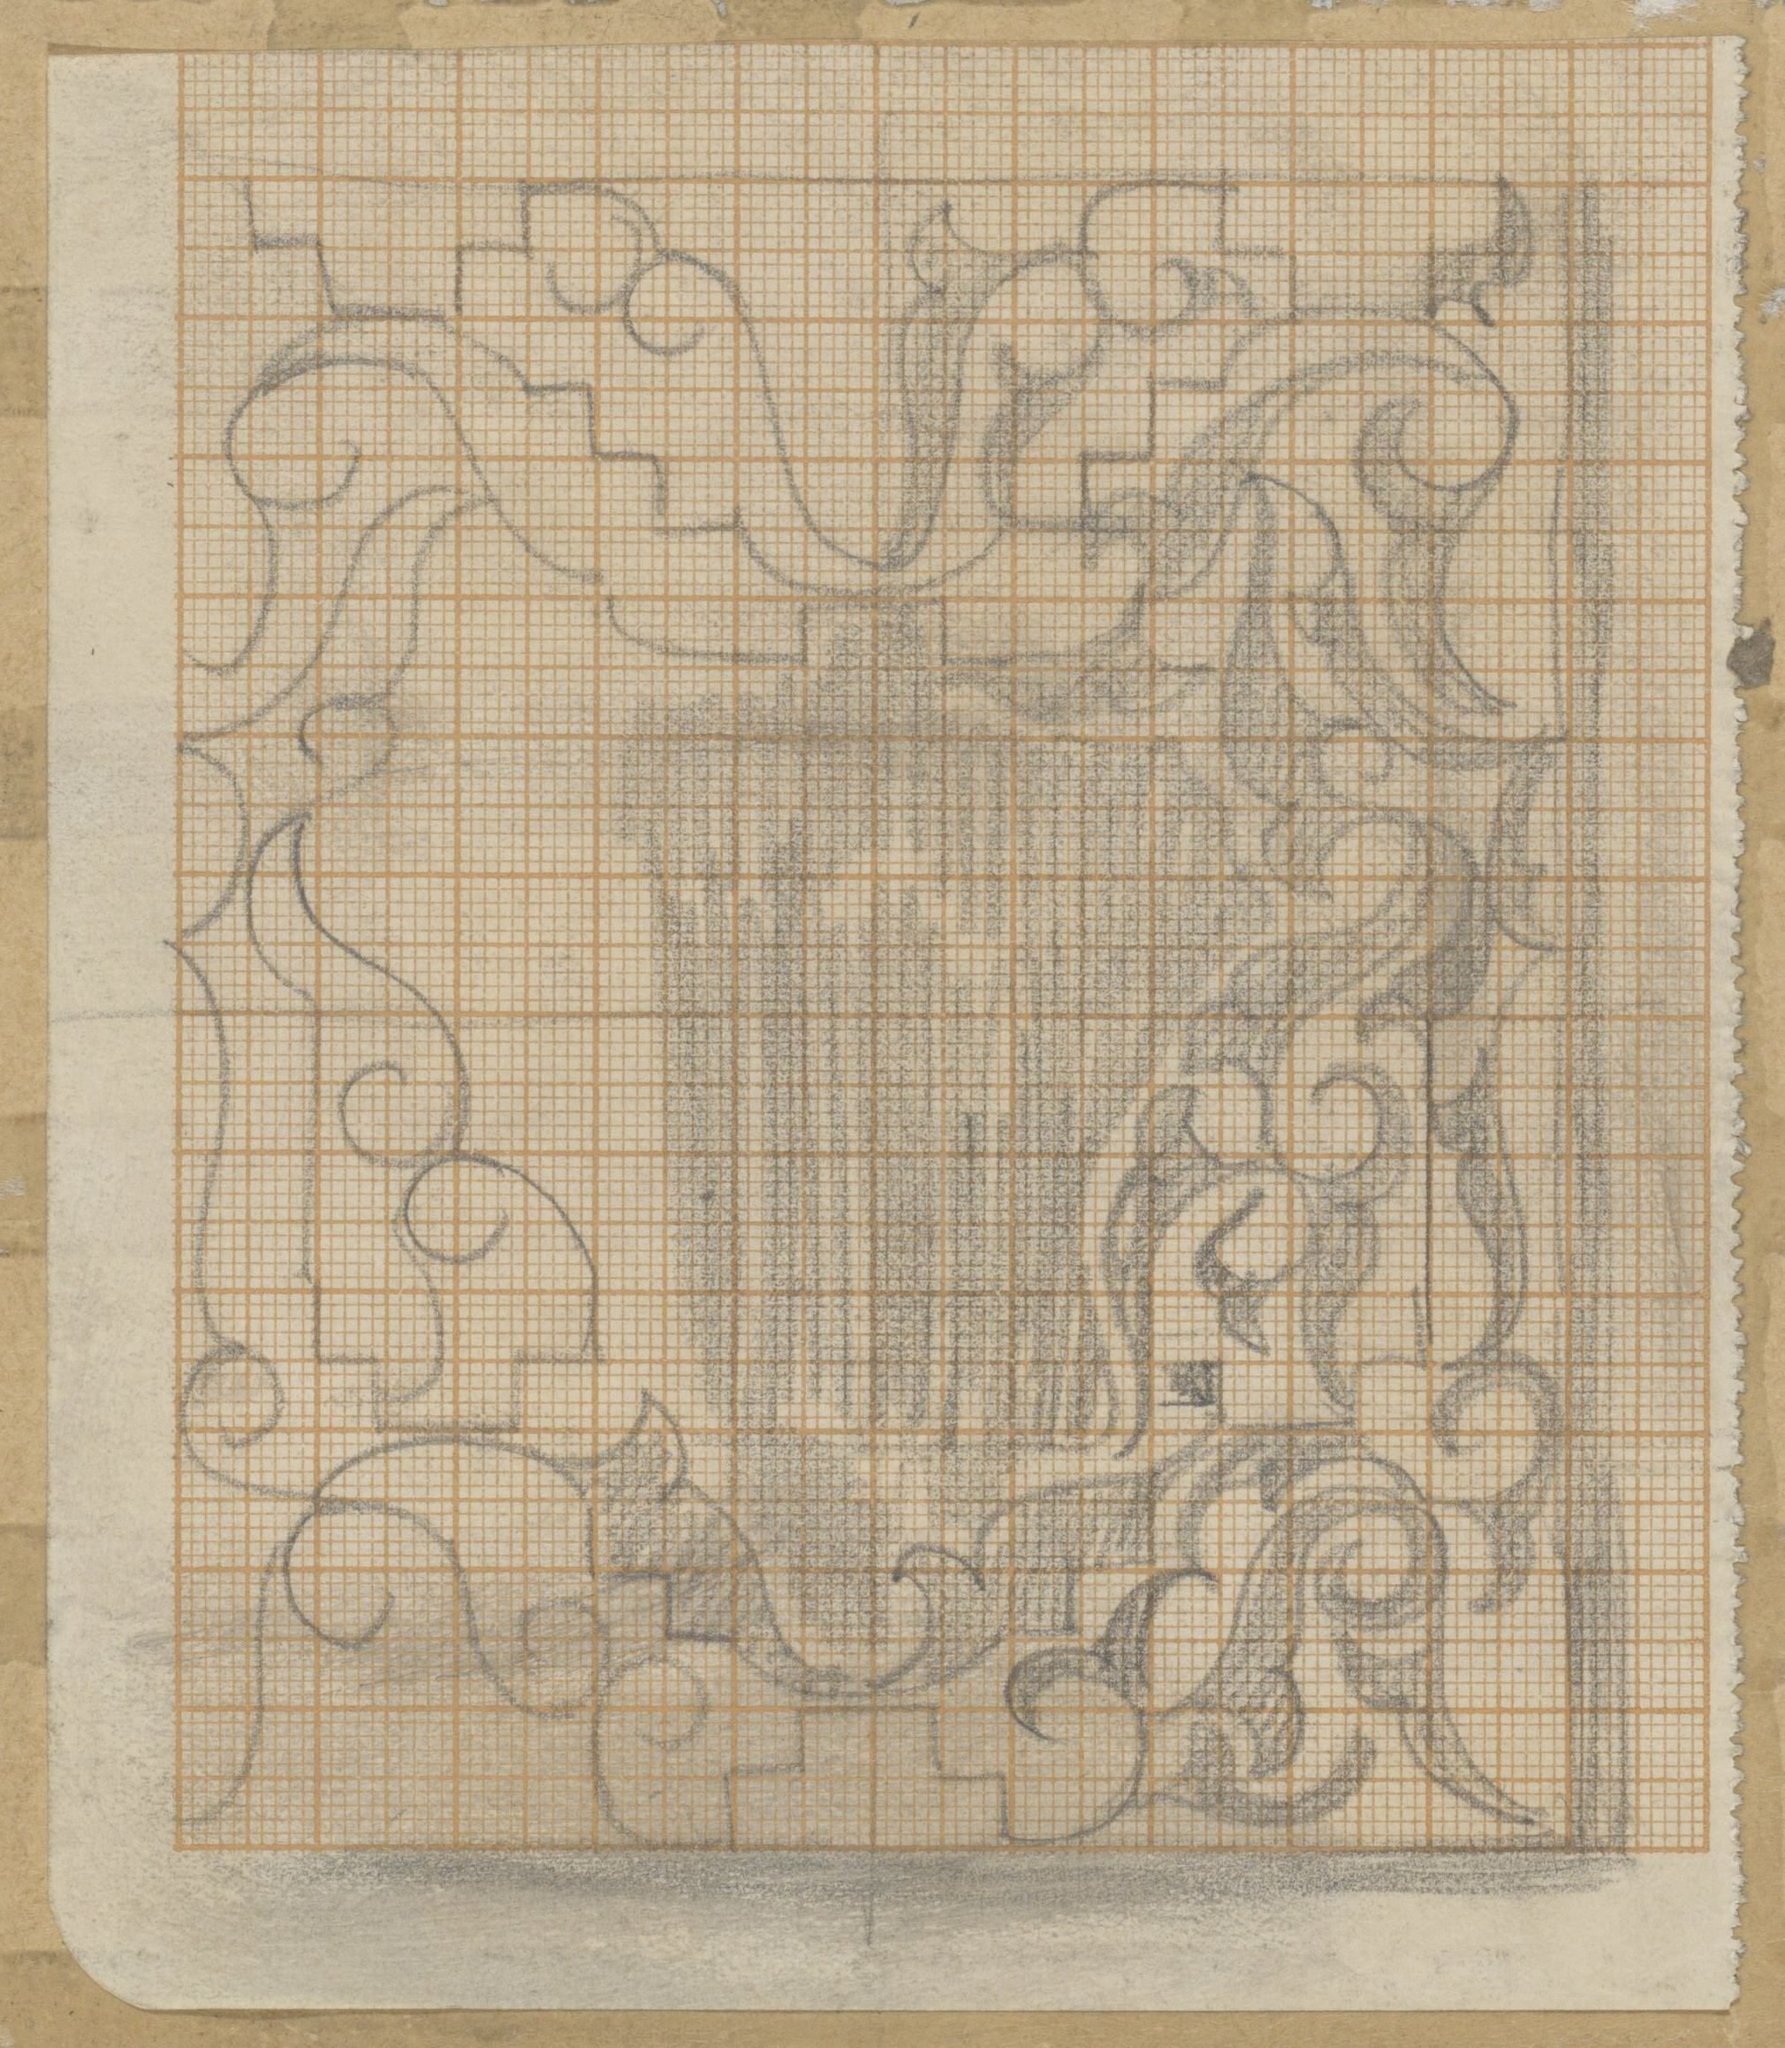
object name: drawing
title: Decoratief ontwerp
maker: carel adolph lion cachet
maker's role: draughtsman, print maker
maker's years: 1864-1945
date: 1874-1945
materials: pencil